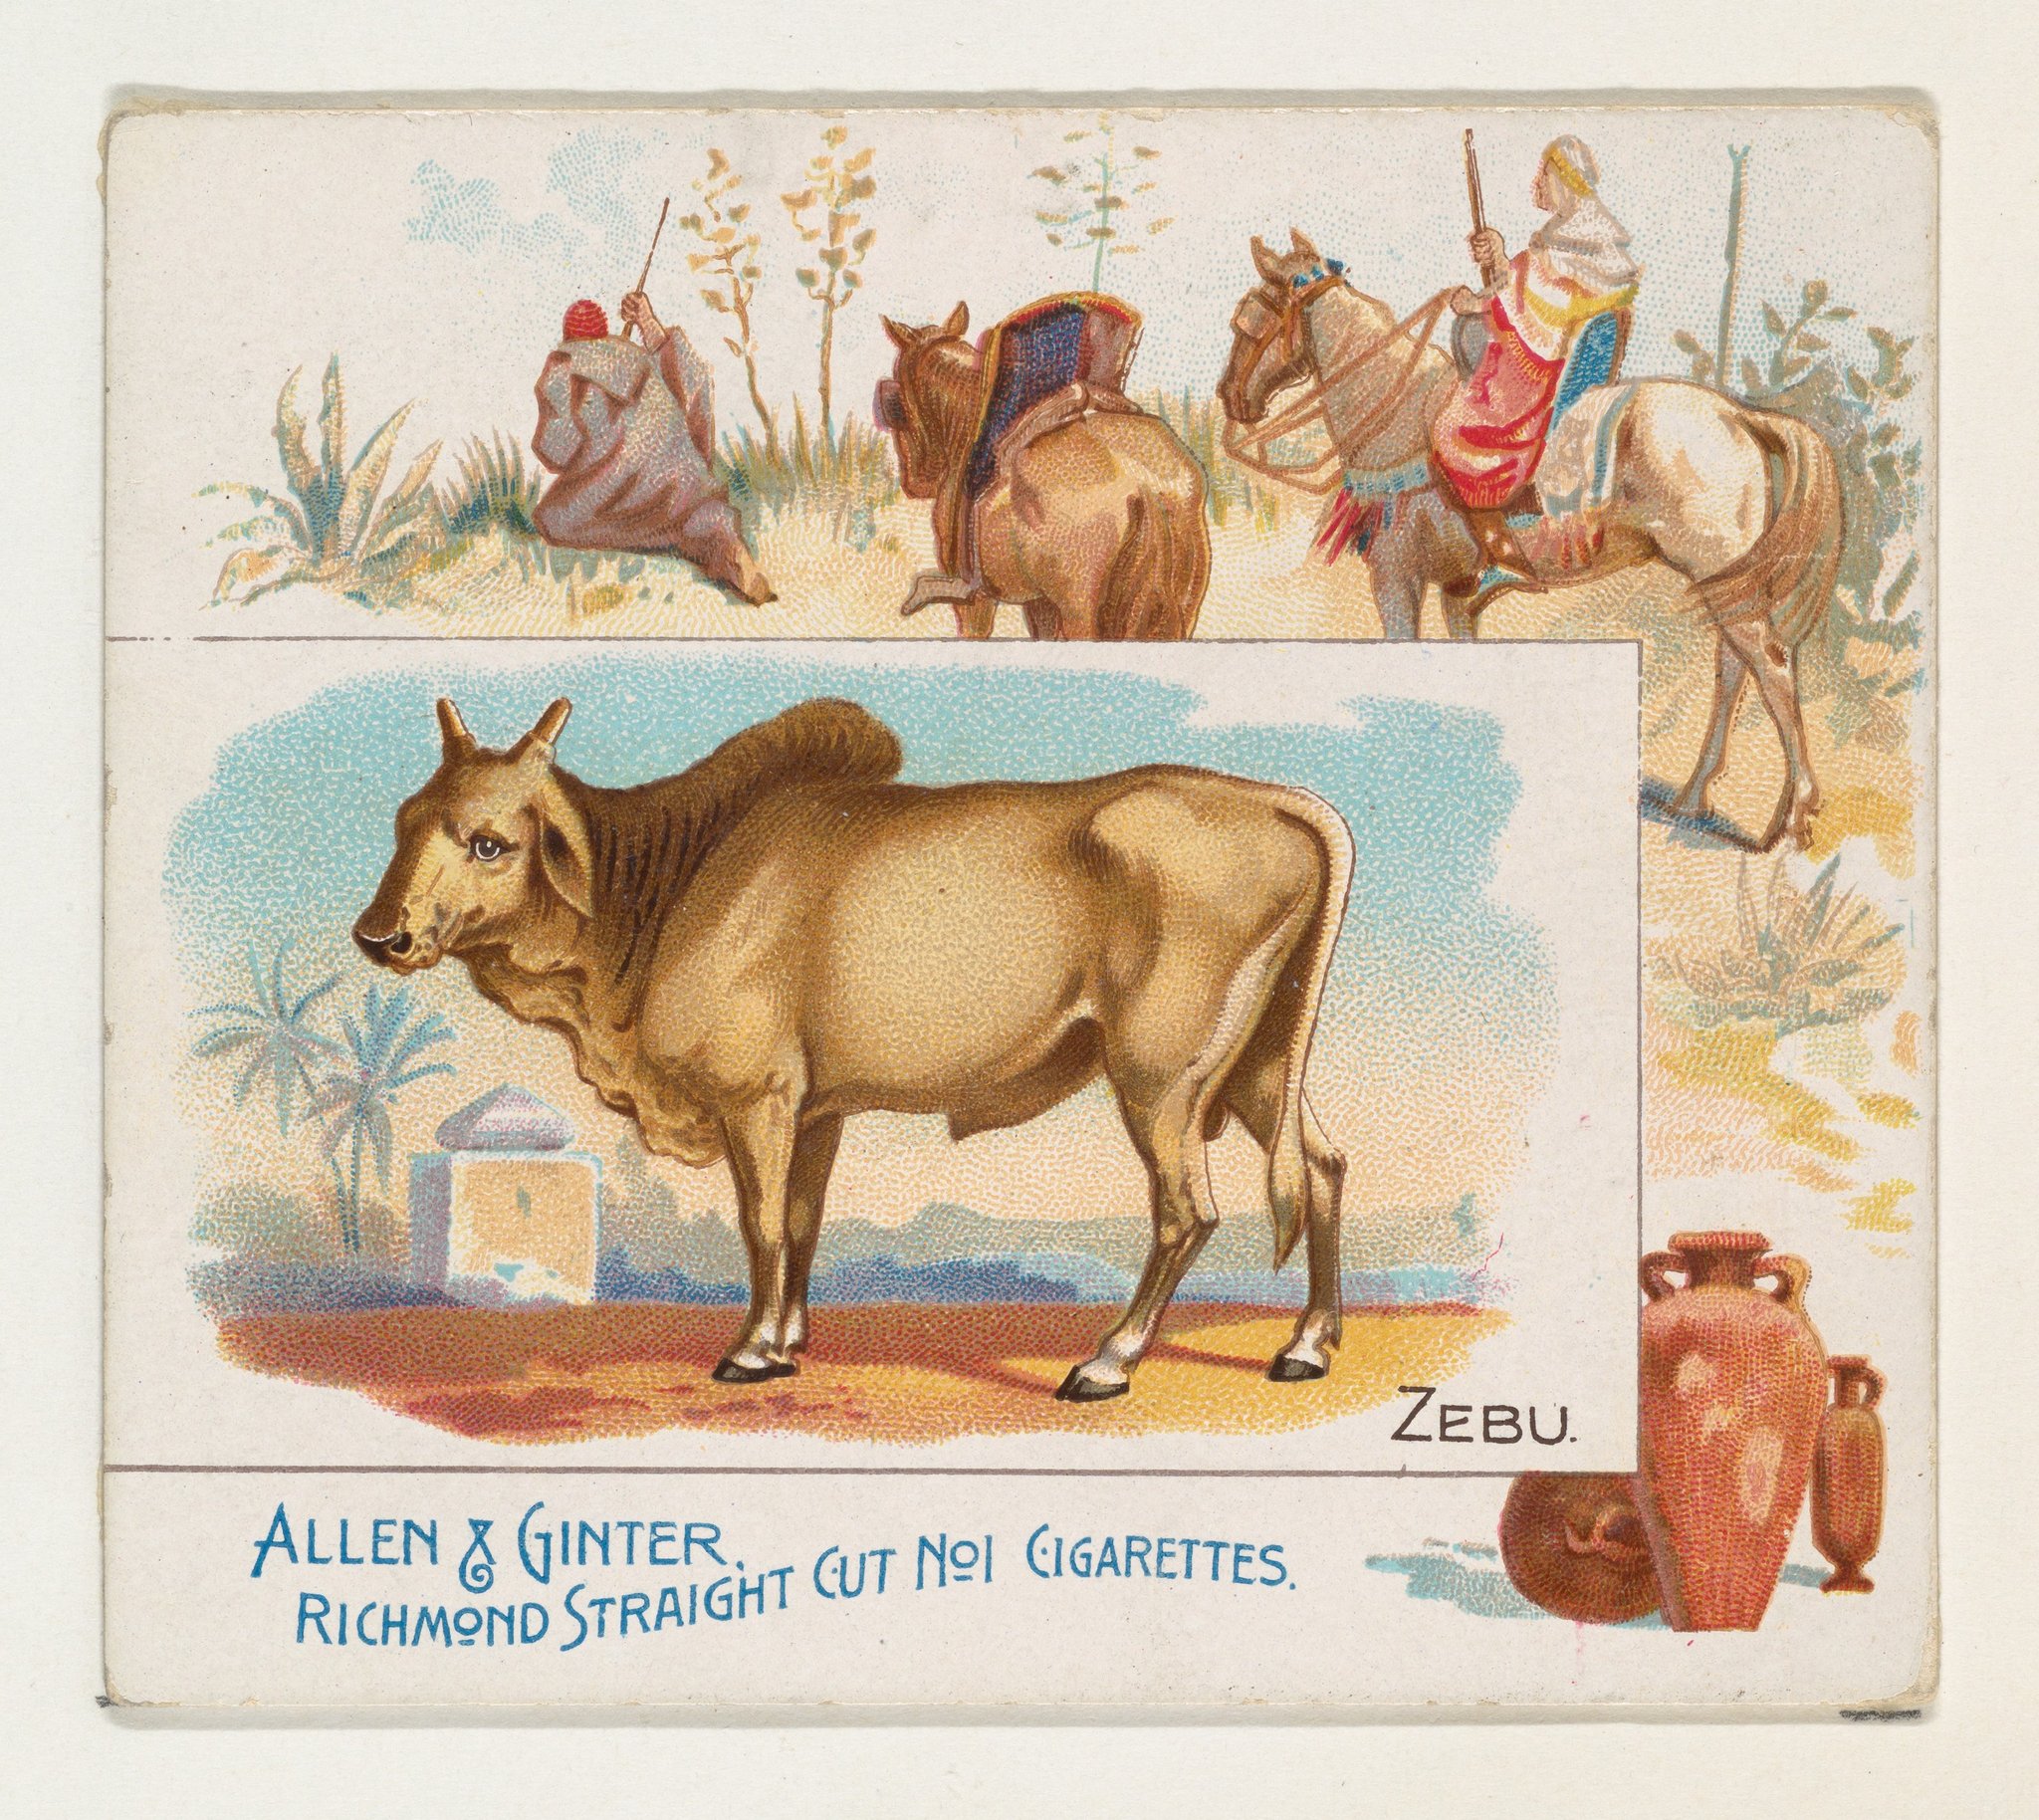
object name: print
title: Zebu, from Quadrupeds series (N41) for Allen & Ginter Cigarettes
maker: allen & ginter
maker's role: publisher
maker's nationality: american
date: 1890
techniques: color lithograph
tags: animals